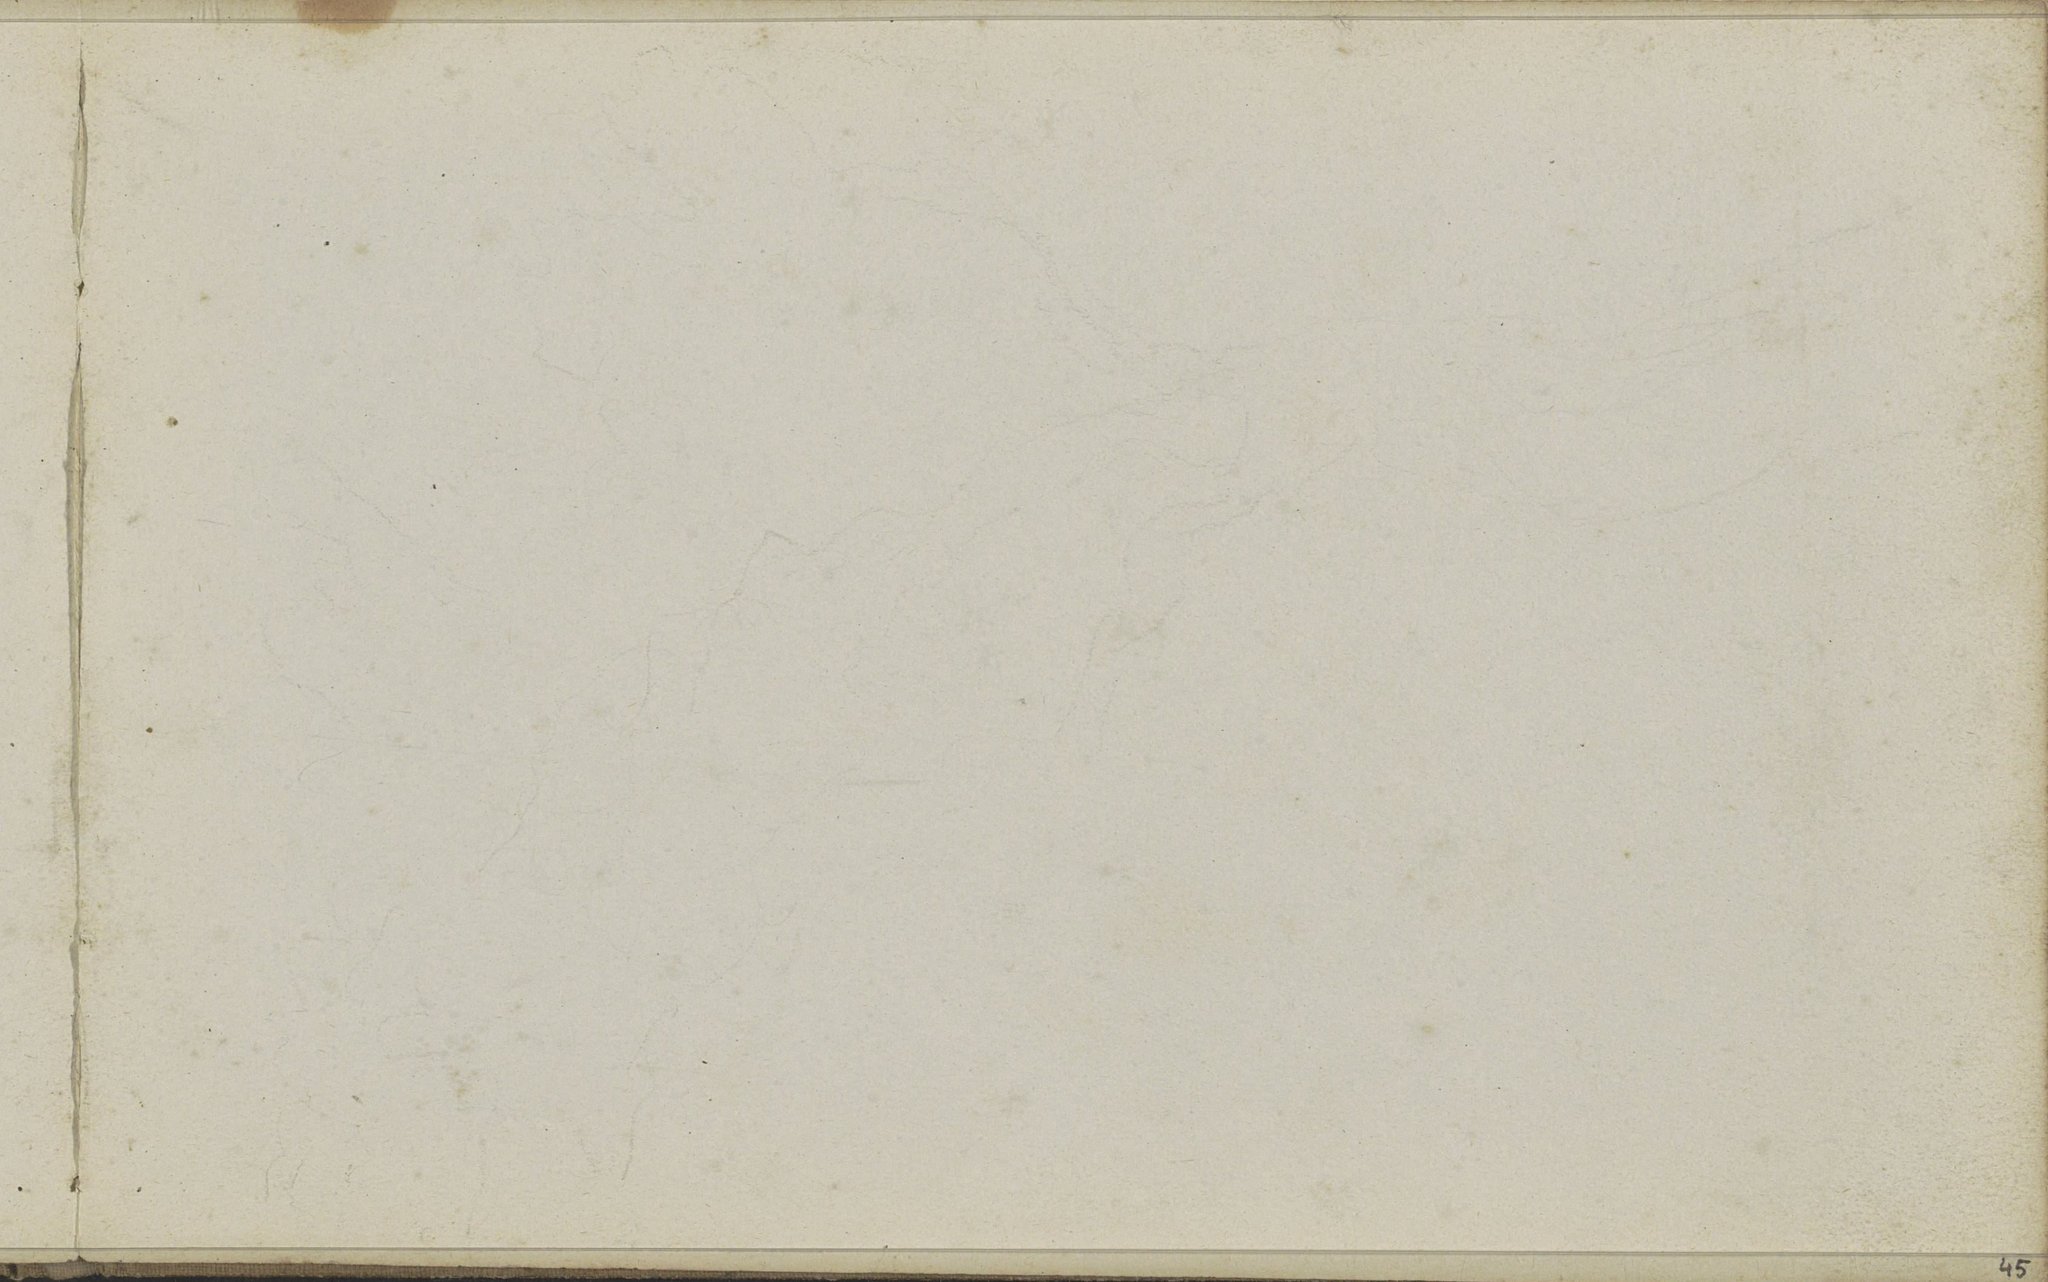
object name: sketchbook leaf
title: Boom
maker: willem cornelis rip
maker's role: draughtsman, painter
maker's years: 1856-1922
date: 1874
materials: paper, pencil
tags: trees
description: Blad 45 recto uit een schetsboek met 47 bladen.